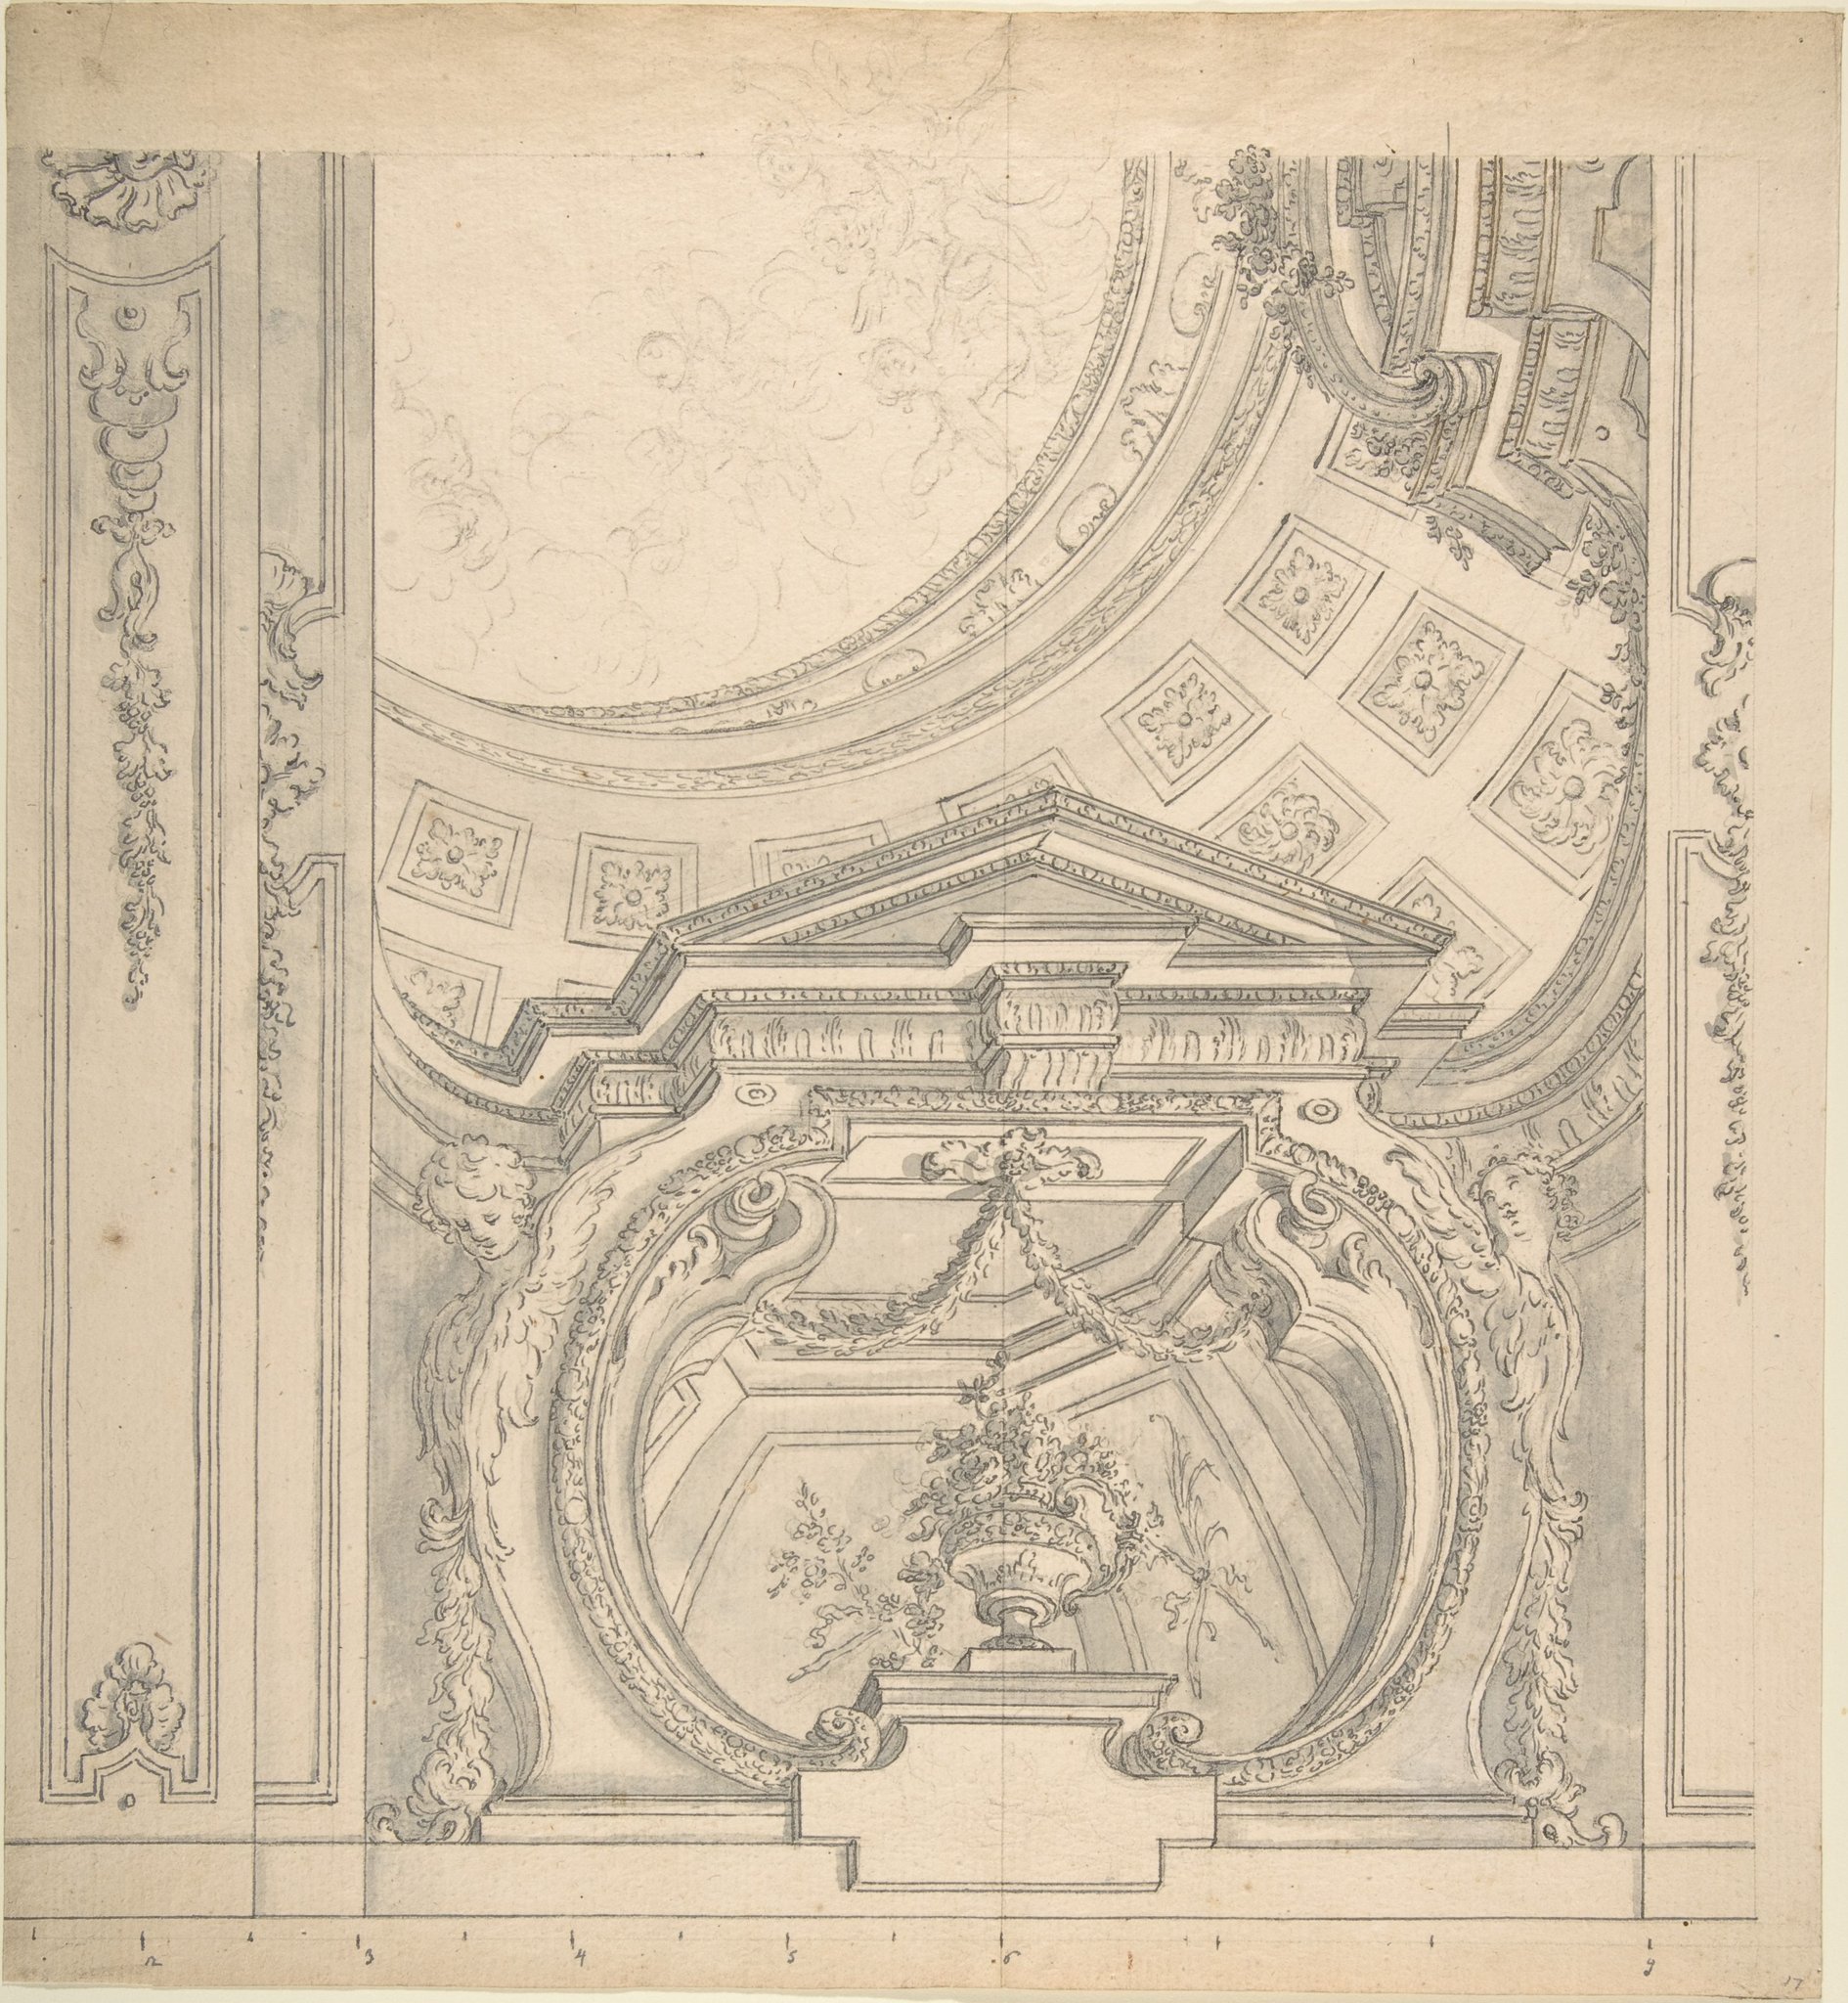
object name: drawing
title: Design for a Ceiling With an Elaborate Cove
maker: anonymous, italian, piedmontese, 18th century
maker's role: artist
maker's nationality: italian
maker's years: 1700-1800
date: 1700-1780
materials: chalk, ink, drawing material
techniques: brush, pen, drawing, wash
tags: faces